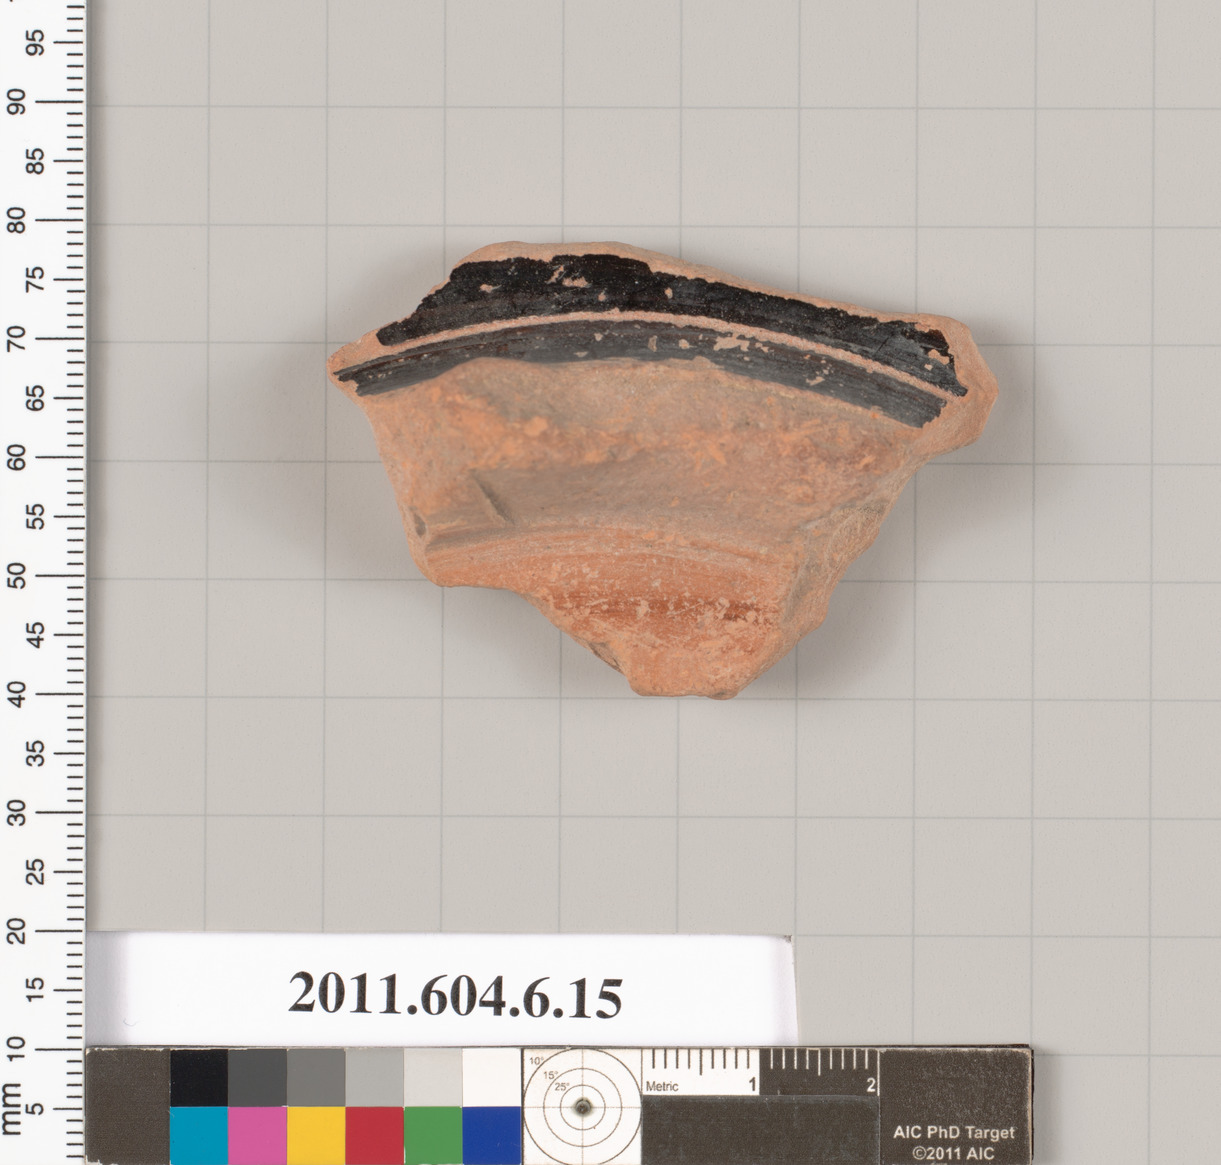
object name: underdetermined open shape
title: Terracotta fragment of an open shape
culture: greek, attic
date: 600-401 BCE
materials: terracotta